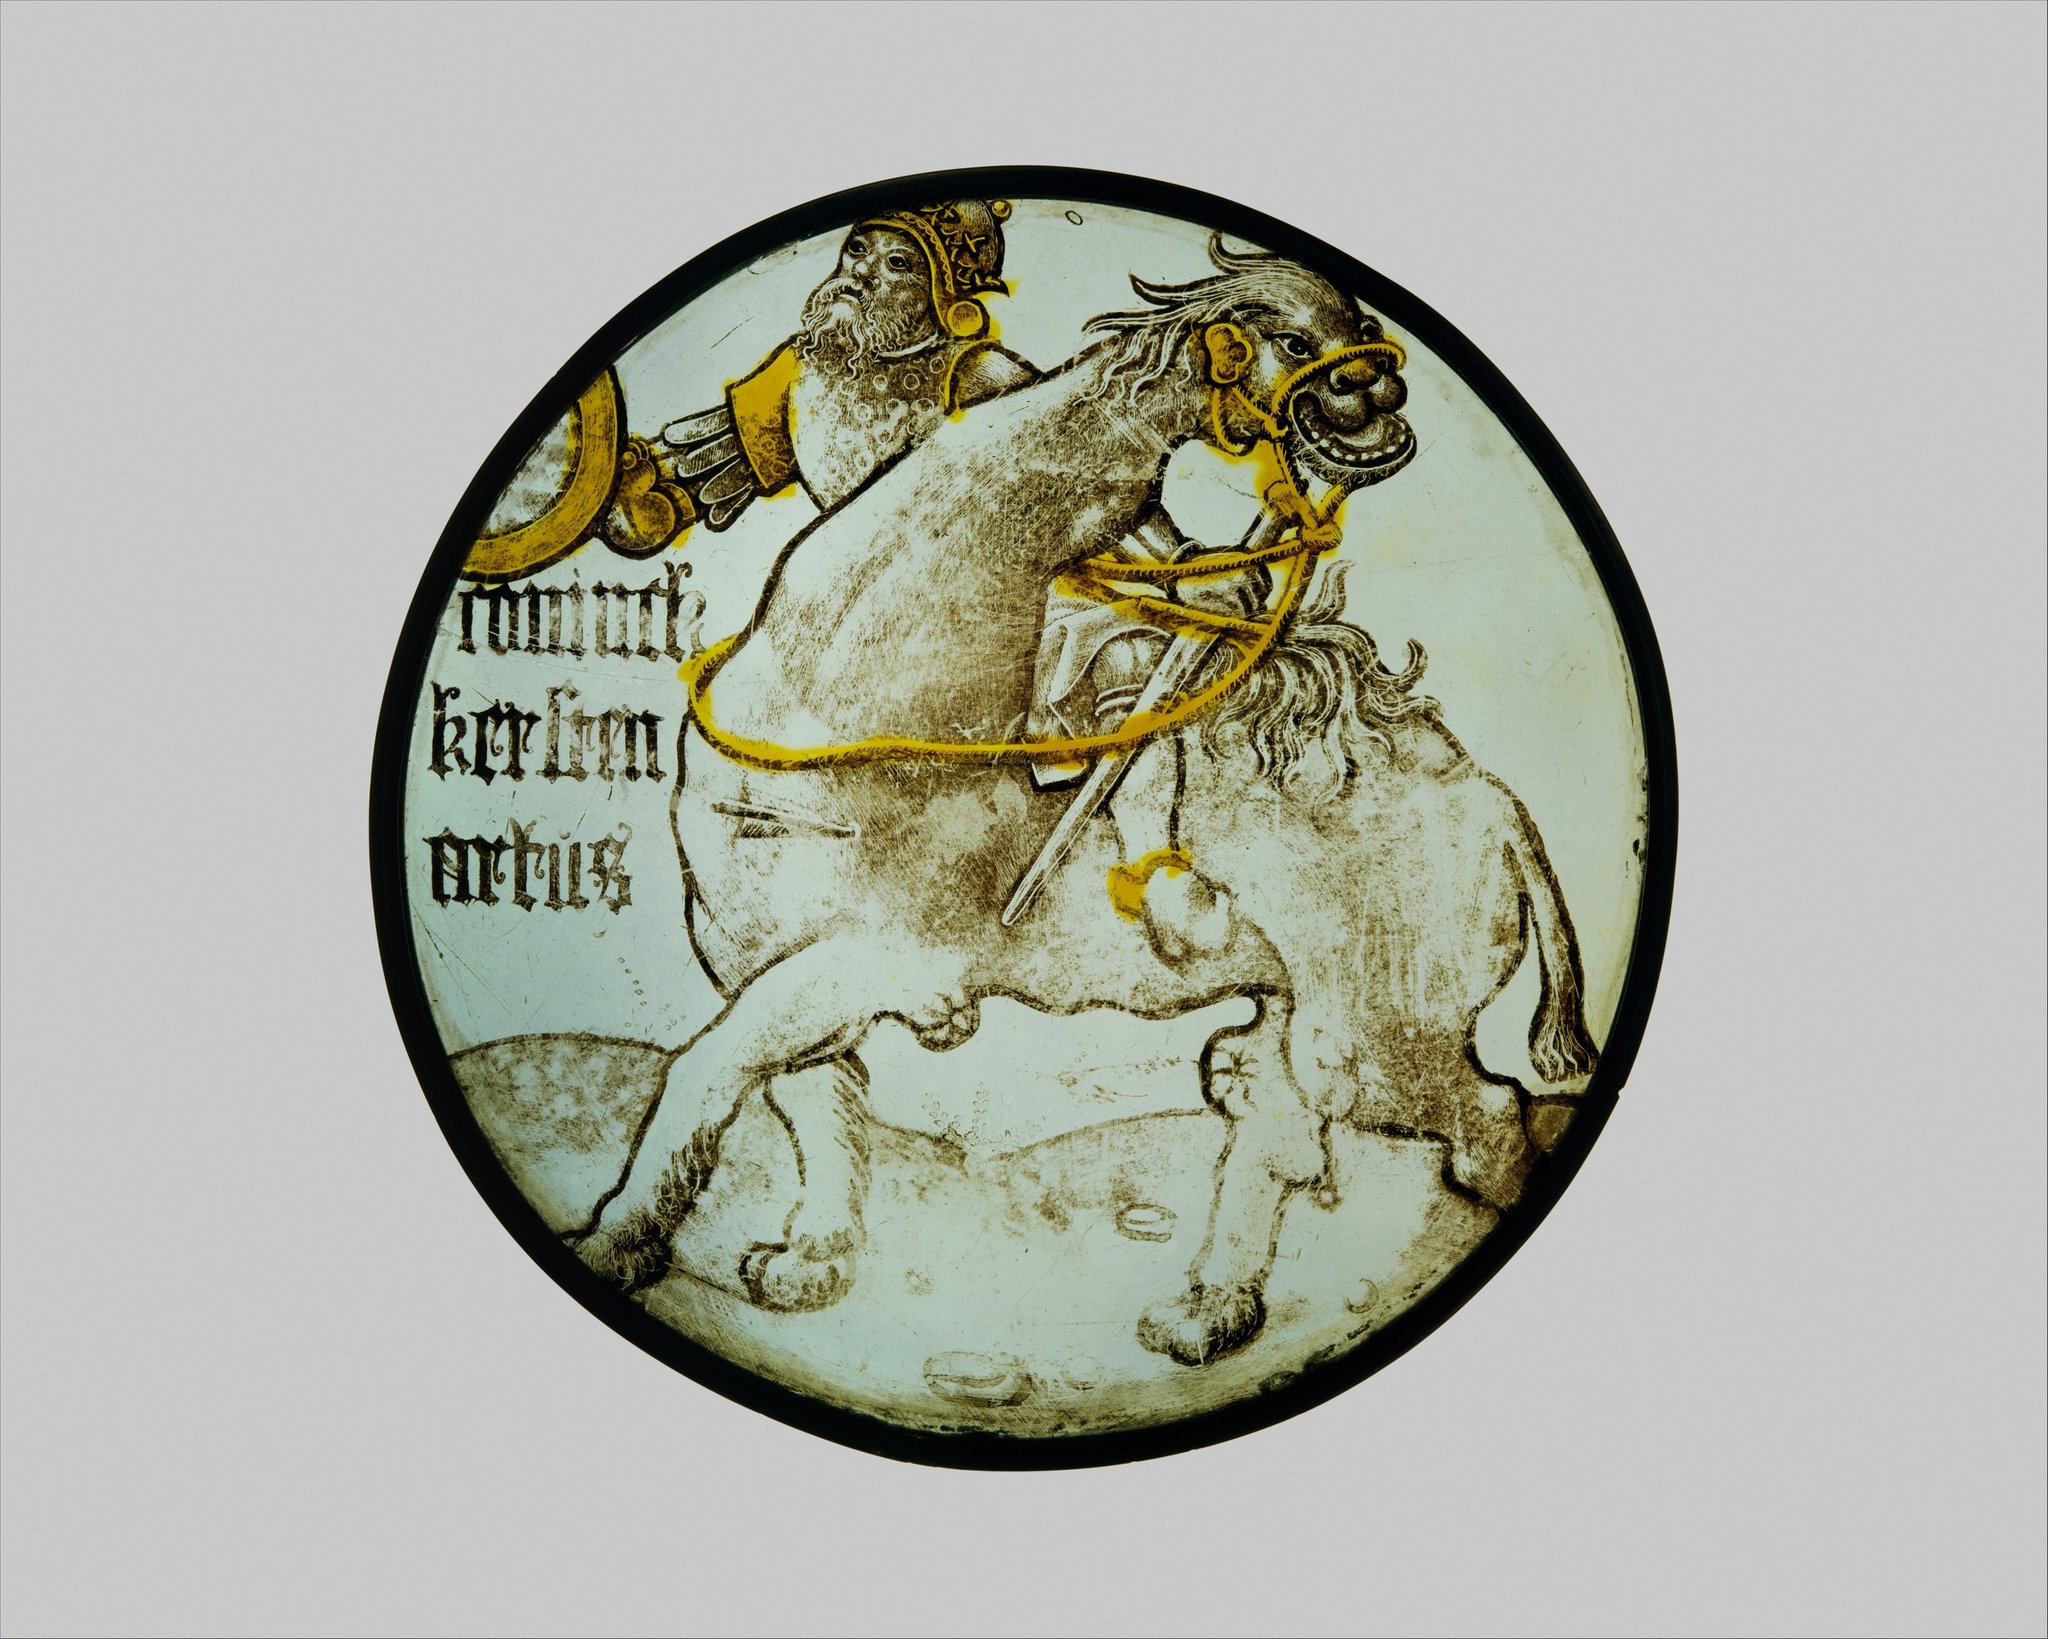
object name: roundel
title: Roundel with King Arthur Riding on a Camel (from a Series of the Nine Heroes)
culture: dutch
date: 1500-1510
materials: glass, paint, pigment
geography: netherlands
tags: kings,camels